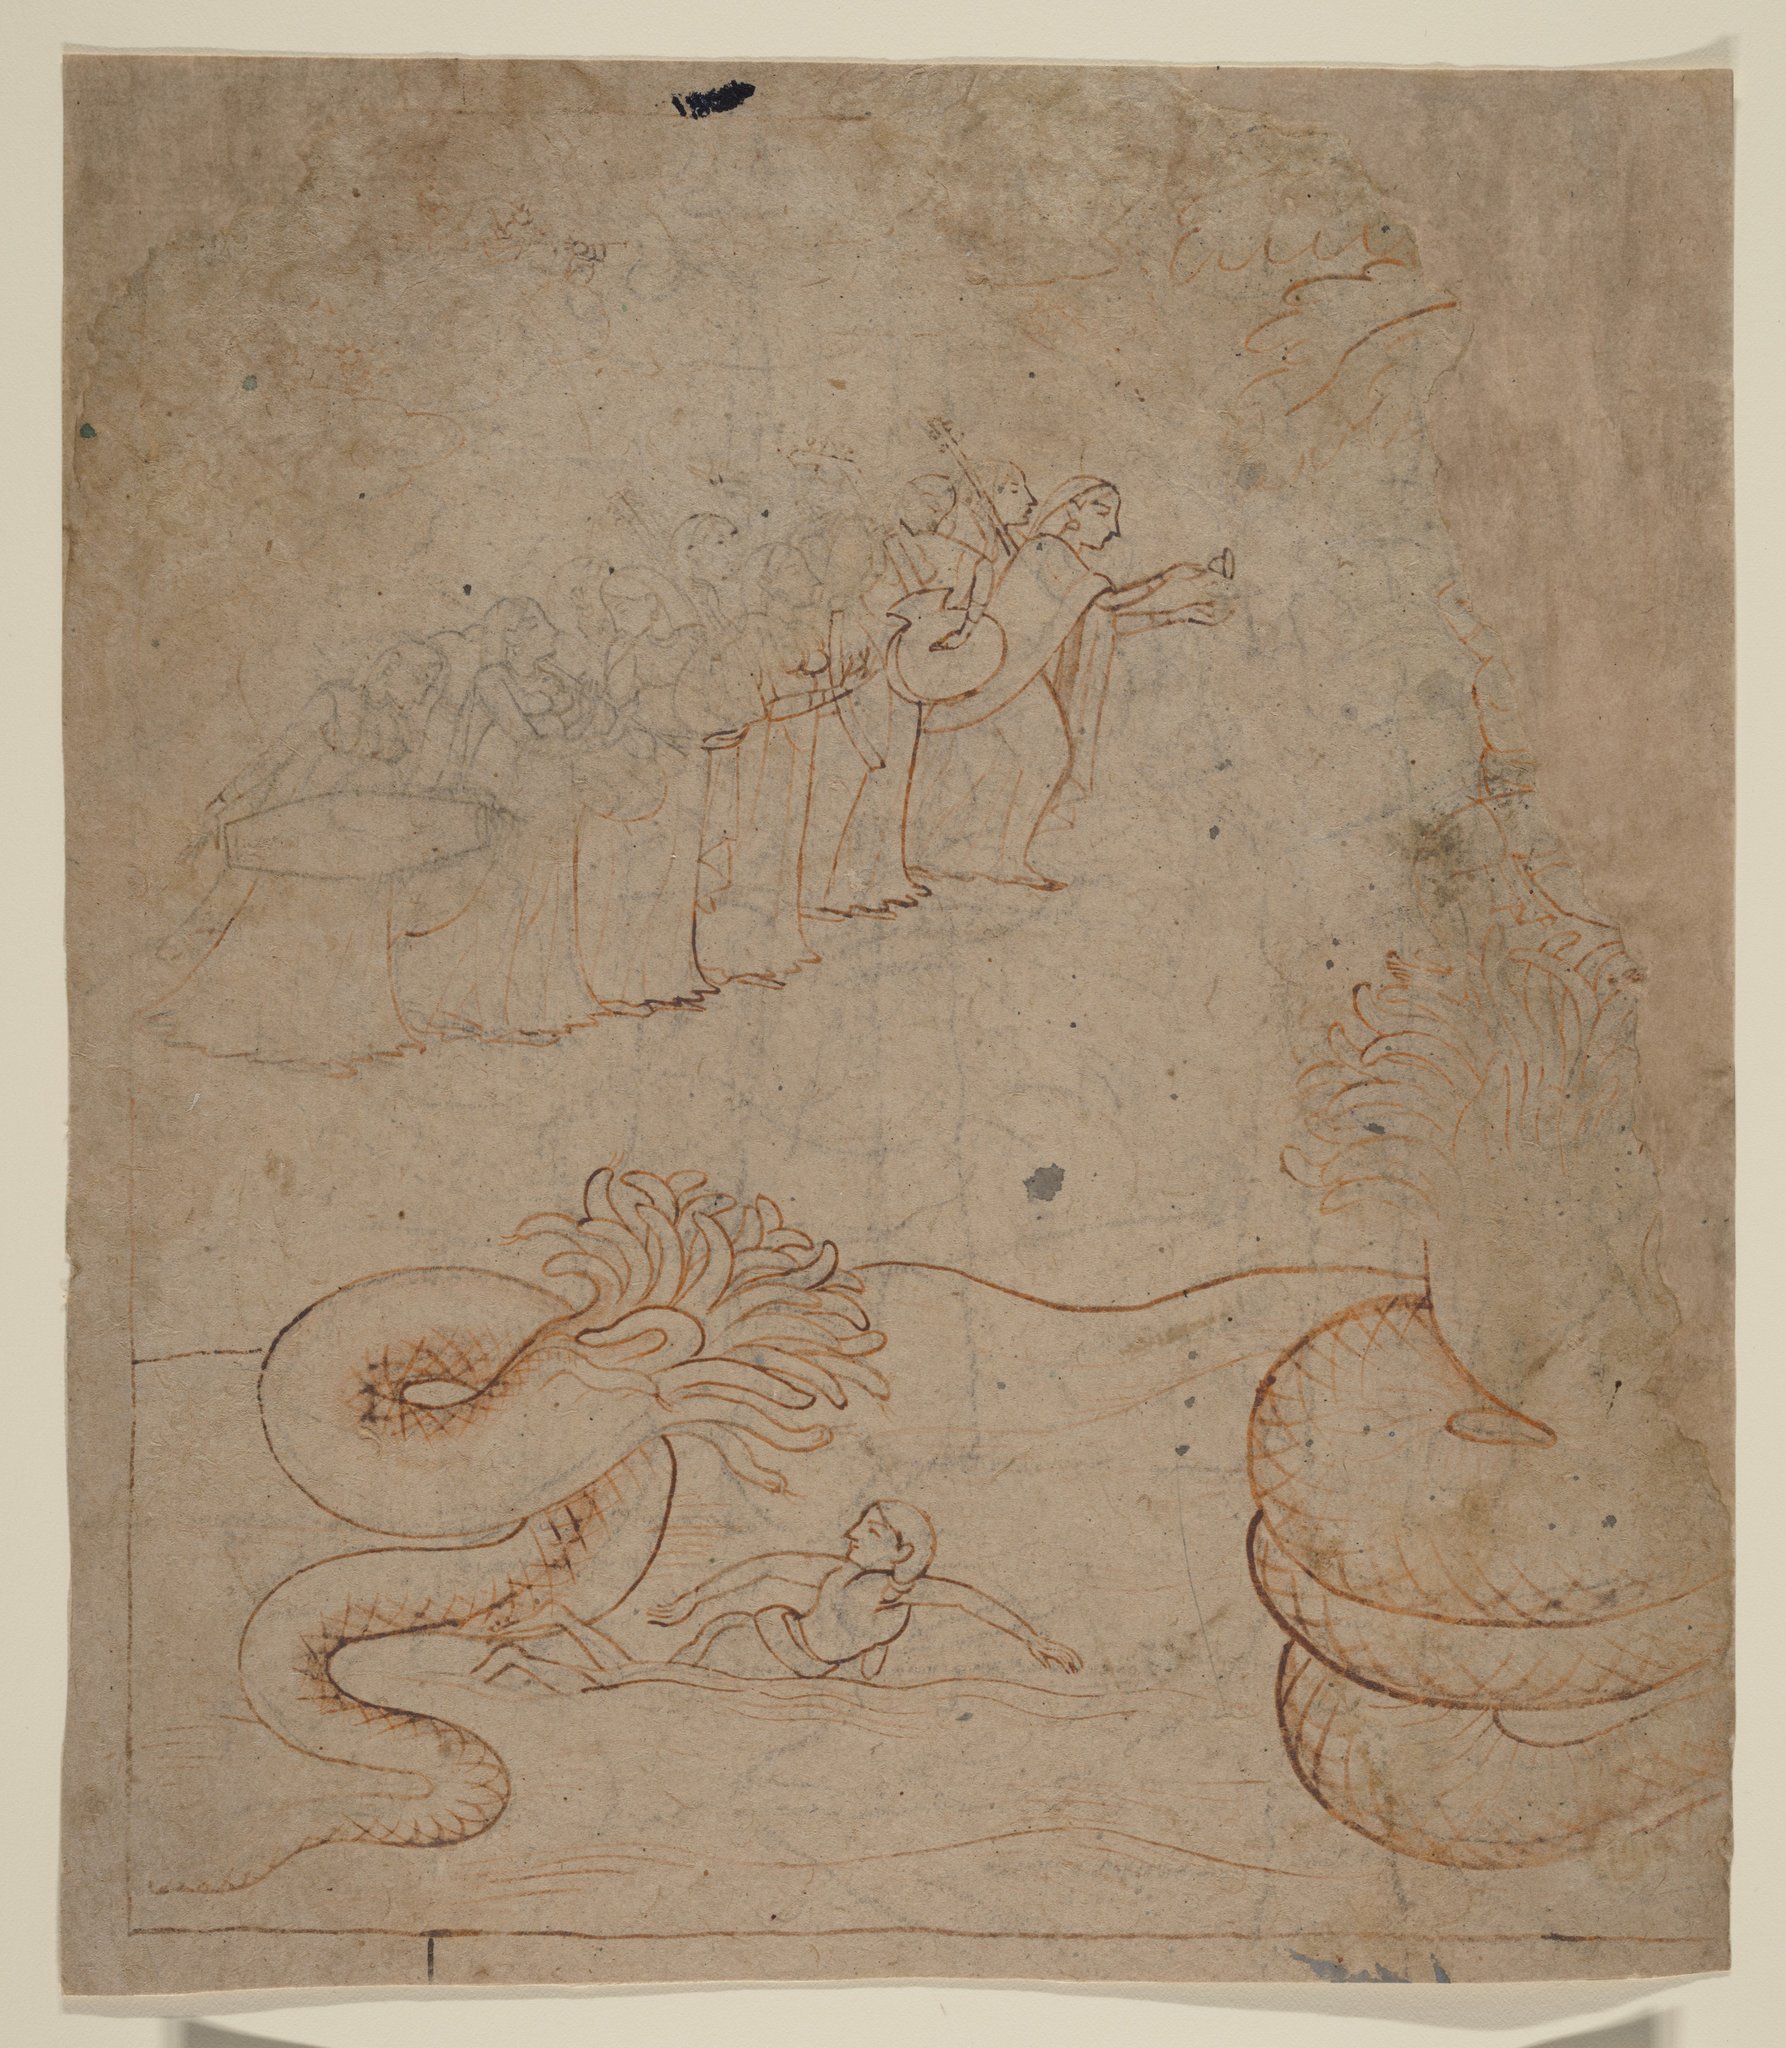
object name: painting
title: Krishna Subdues the Serpent Kaliya in the Yamuna River: Illustration from a Bhagavata Purana Series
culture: indian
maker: nainsukh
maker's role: artist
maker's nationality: indian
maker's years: 1725-1778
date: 1780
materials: ink, paper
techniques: wash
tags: women,serpents,krishna